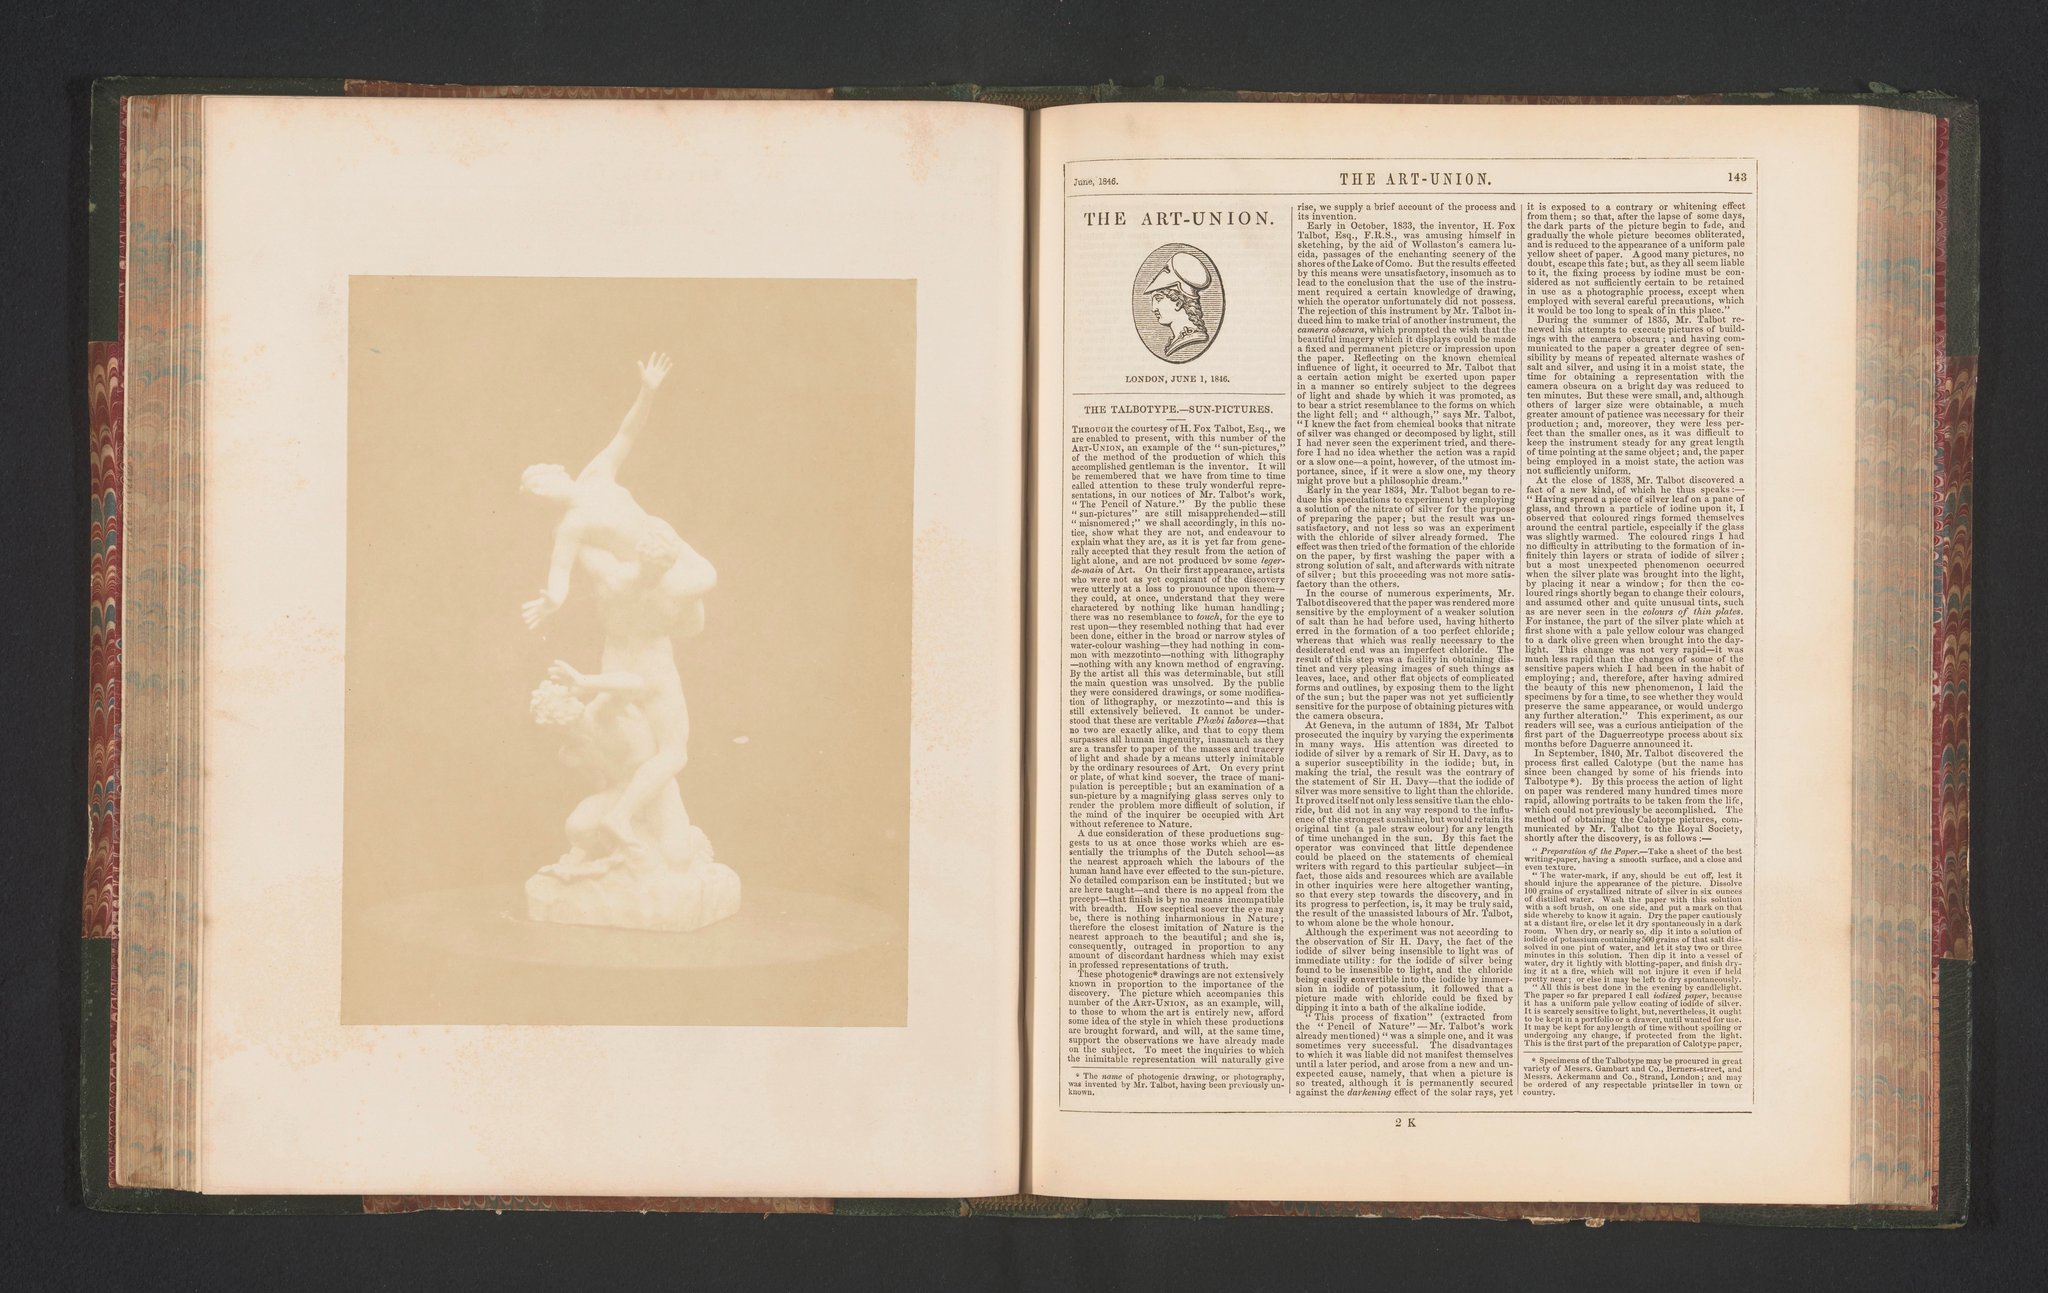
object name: photograph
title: Porseleinen beeld naar Giambologna, voorstellende de Sabijnse maagdenroof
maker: william henry fox talbot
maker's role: fotograaf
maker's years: 1800-1877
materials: photographic support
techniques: salted paper print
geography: france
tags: rape of the sabine women: they are carried off by romulus and his men during a feast, sculpture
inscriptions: inscription: ‘Patent Talbotype or sun pictures. A great variety of specimens On sale at Messrs. Brooks (Brothers), 87, New Bond Street, London.’